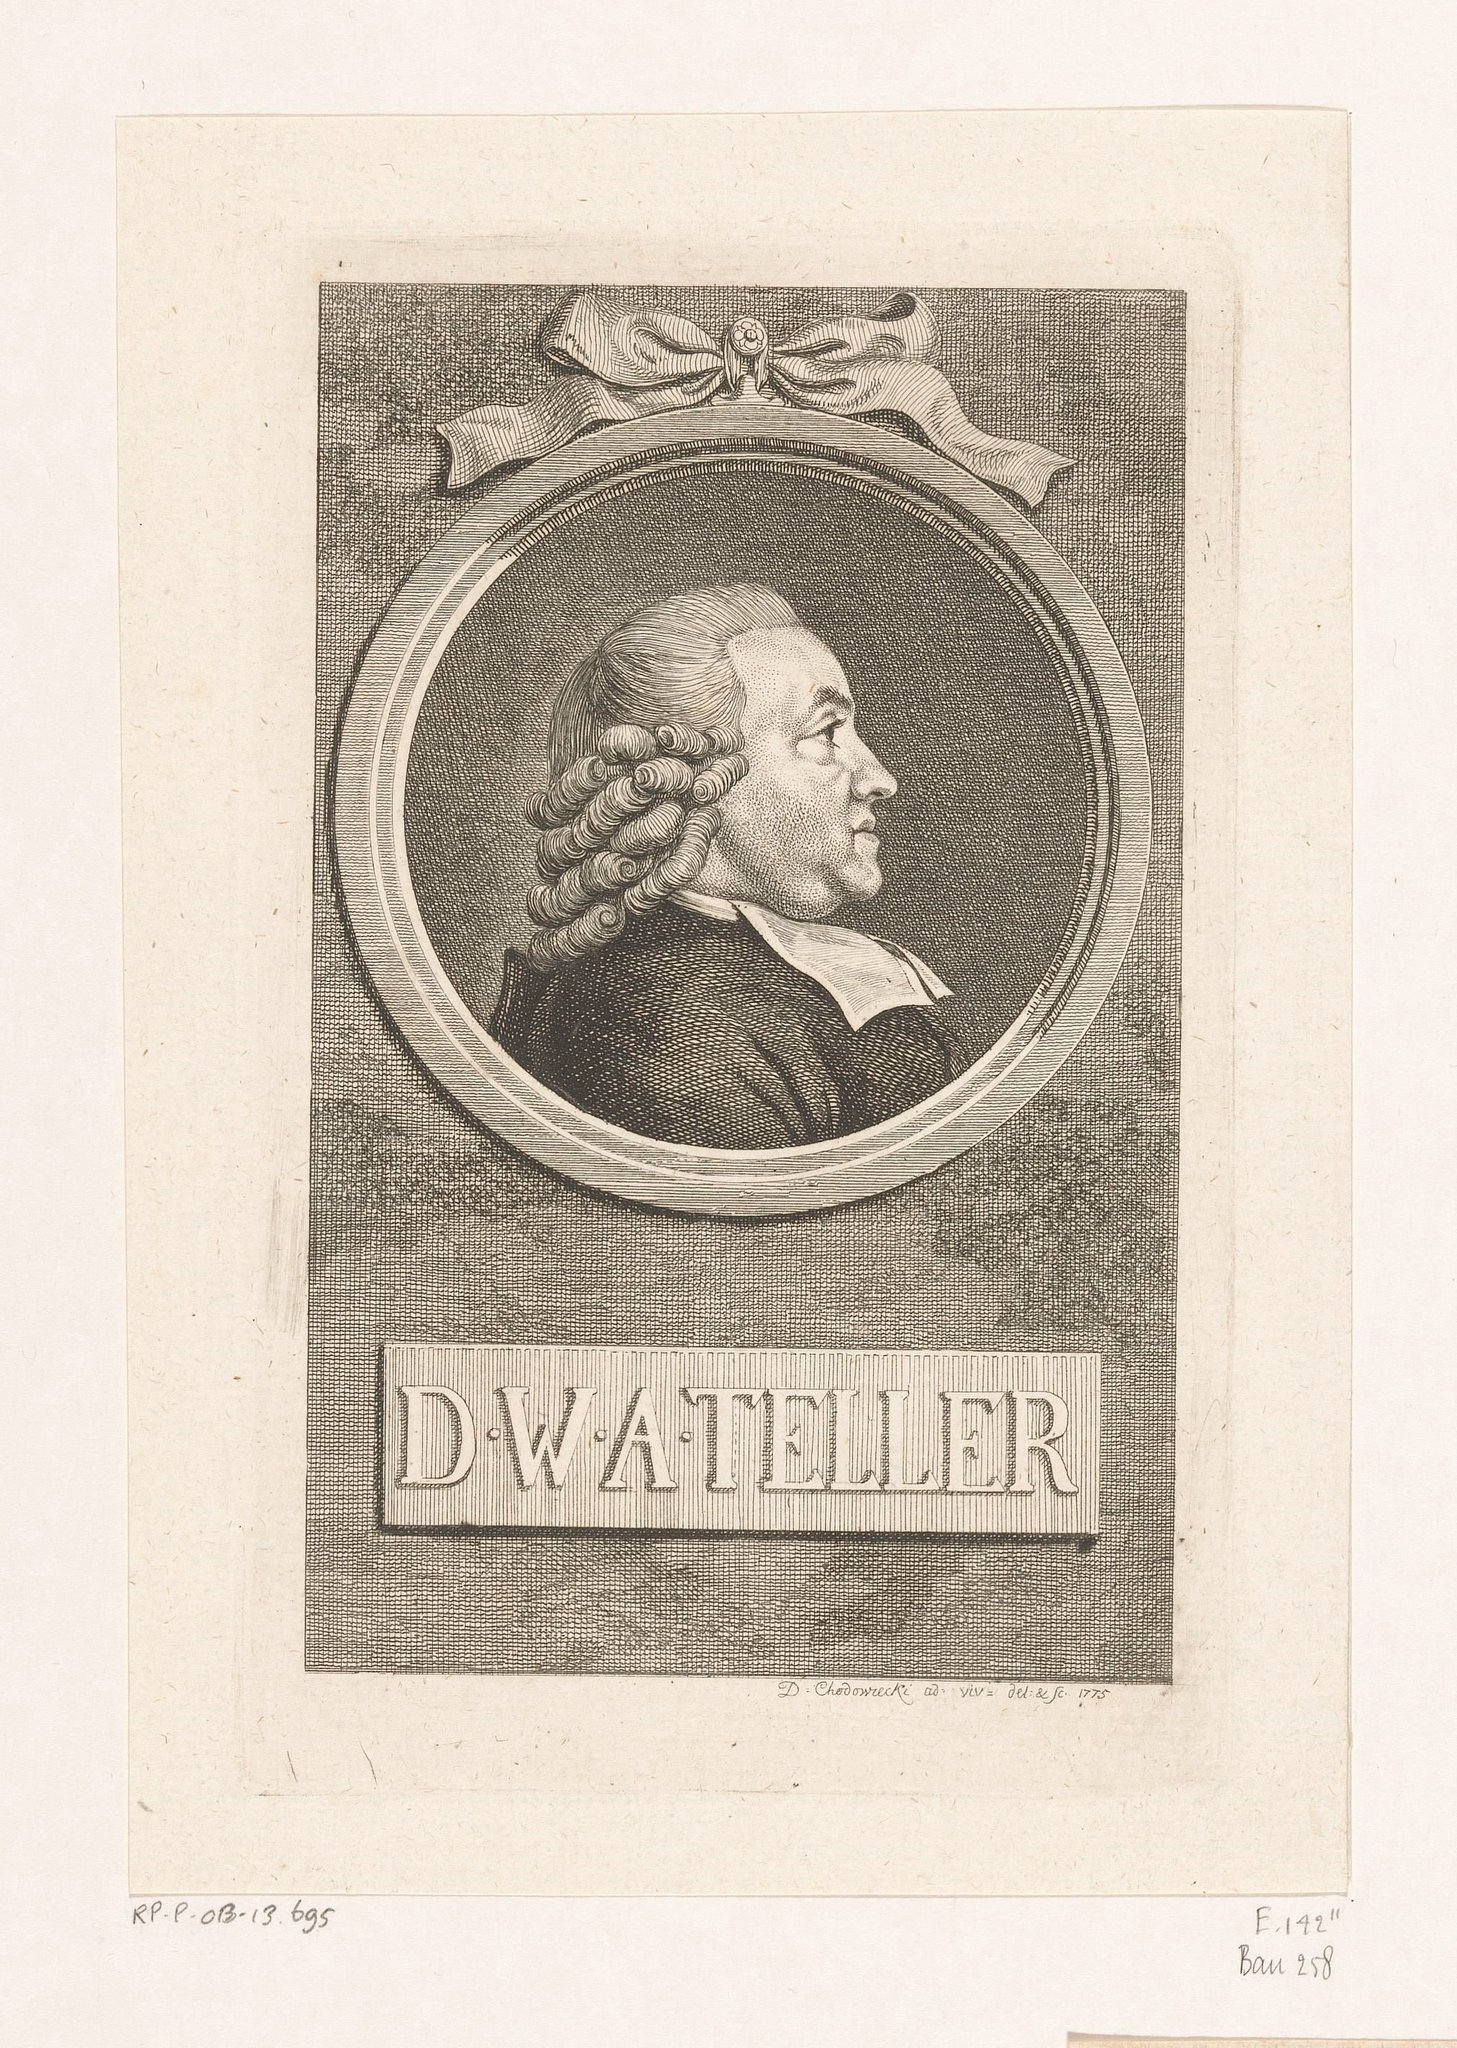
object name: print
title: Portret van Wilhelm Abraham Teller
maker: daniel nikolaus chodowiecki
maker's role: draughtsman, print maker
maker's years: 1726-1801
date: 1775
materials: paper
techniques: etching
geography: berlin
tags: berlin, historical persons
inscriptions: collector's mark: Lugt 2228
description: Prent ook gebruikt in: Allgemeine deutsche Bibliothek. Berlijn en Stettin: Friedrich Nicolai, dl. 28, eerste stuk.